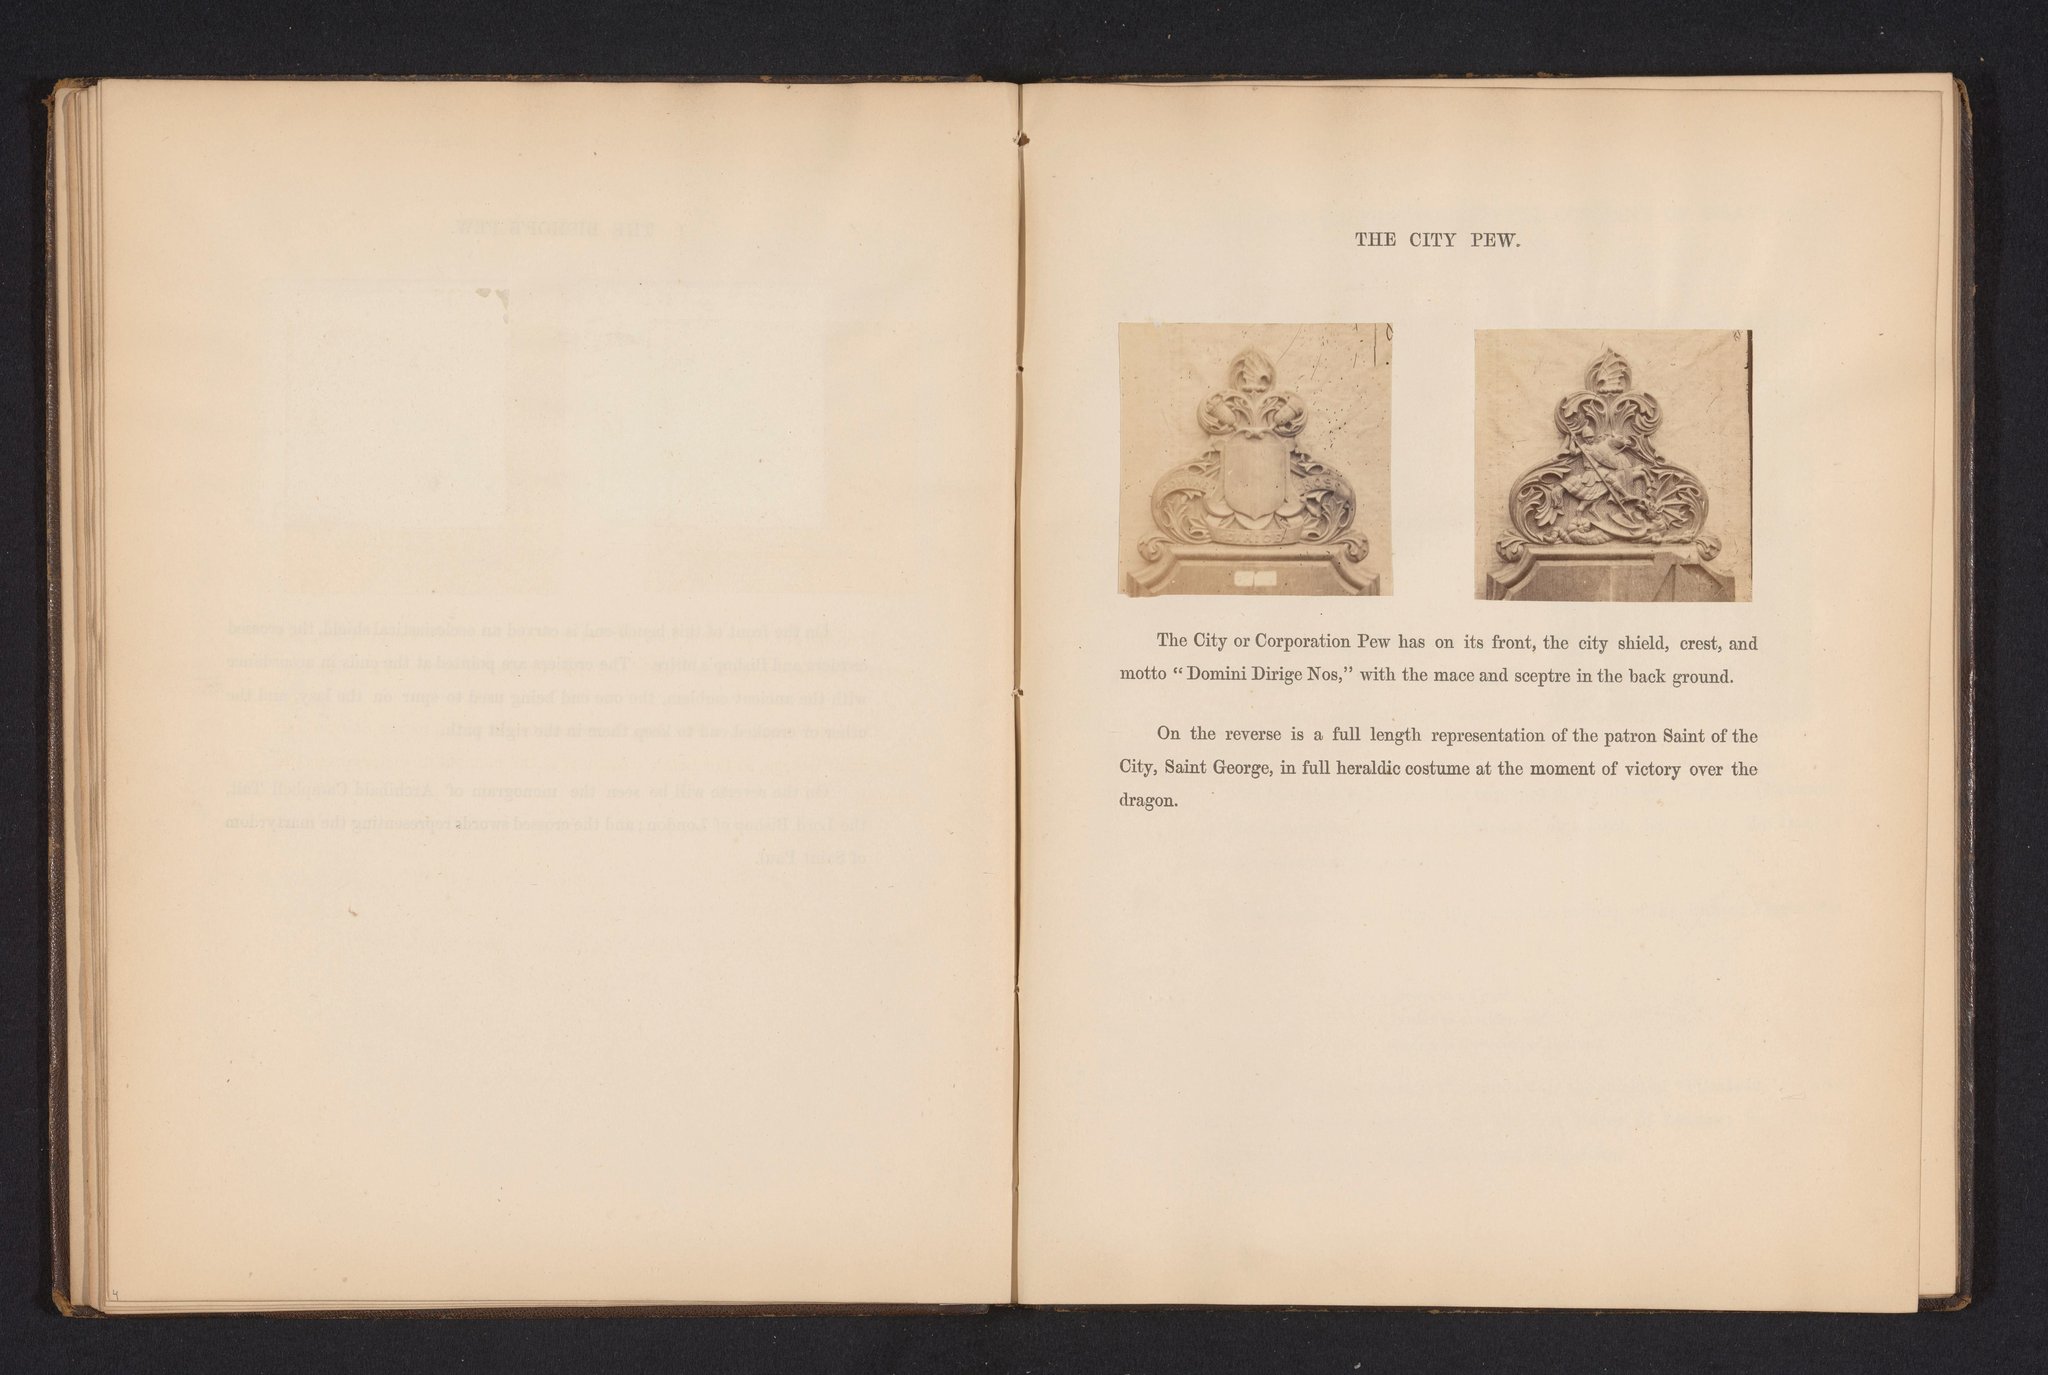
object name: page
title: The City pew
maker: Anonymous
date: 1857-1867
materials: photographic support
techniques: albumen print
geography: st michael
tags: coat of arms (as symbol of the state, etc.), bench, the warrior martyr george (georgius); possible attributes: banner (red cross on white field), (red) cross, dragon, (white) horse, broken lance, shield (with cross), sword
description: Links: een wapenschild, rechts: Joris die een draak dood.